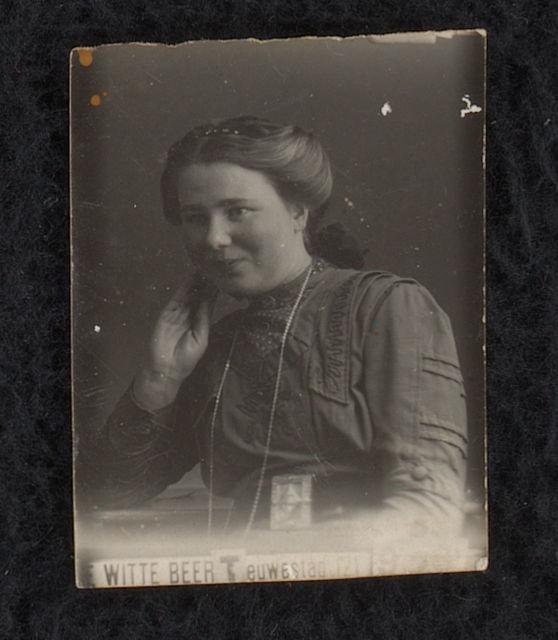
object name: snapshot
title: Portret van een onbekende vrouw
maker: Anonymous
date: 1912-1916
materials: paper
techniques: gelatin silver print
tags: anonymous historical person portrayed - bb - woman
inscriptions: number: ‘147’